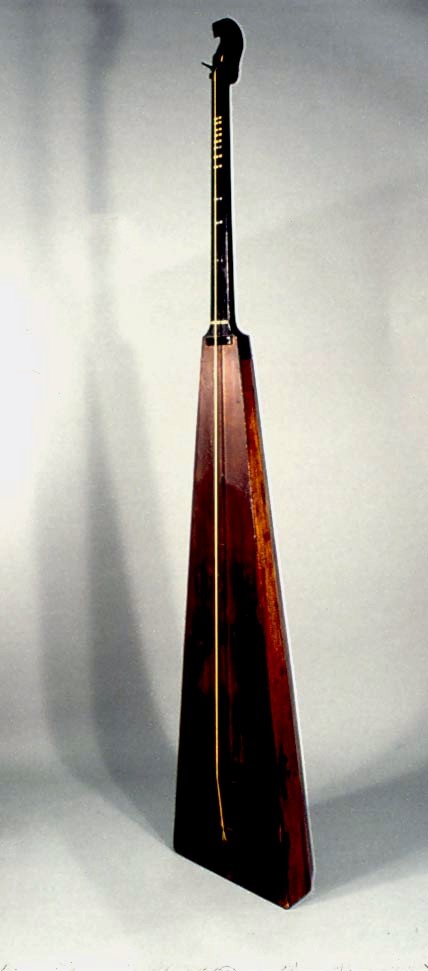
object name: tromba marina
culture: german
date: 1850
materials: iron, wood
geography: germany